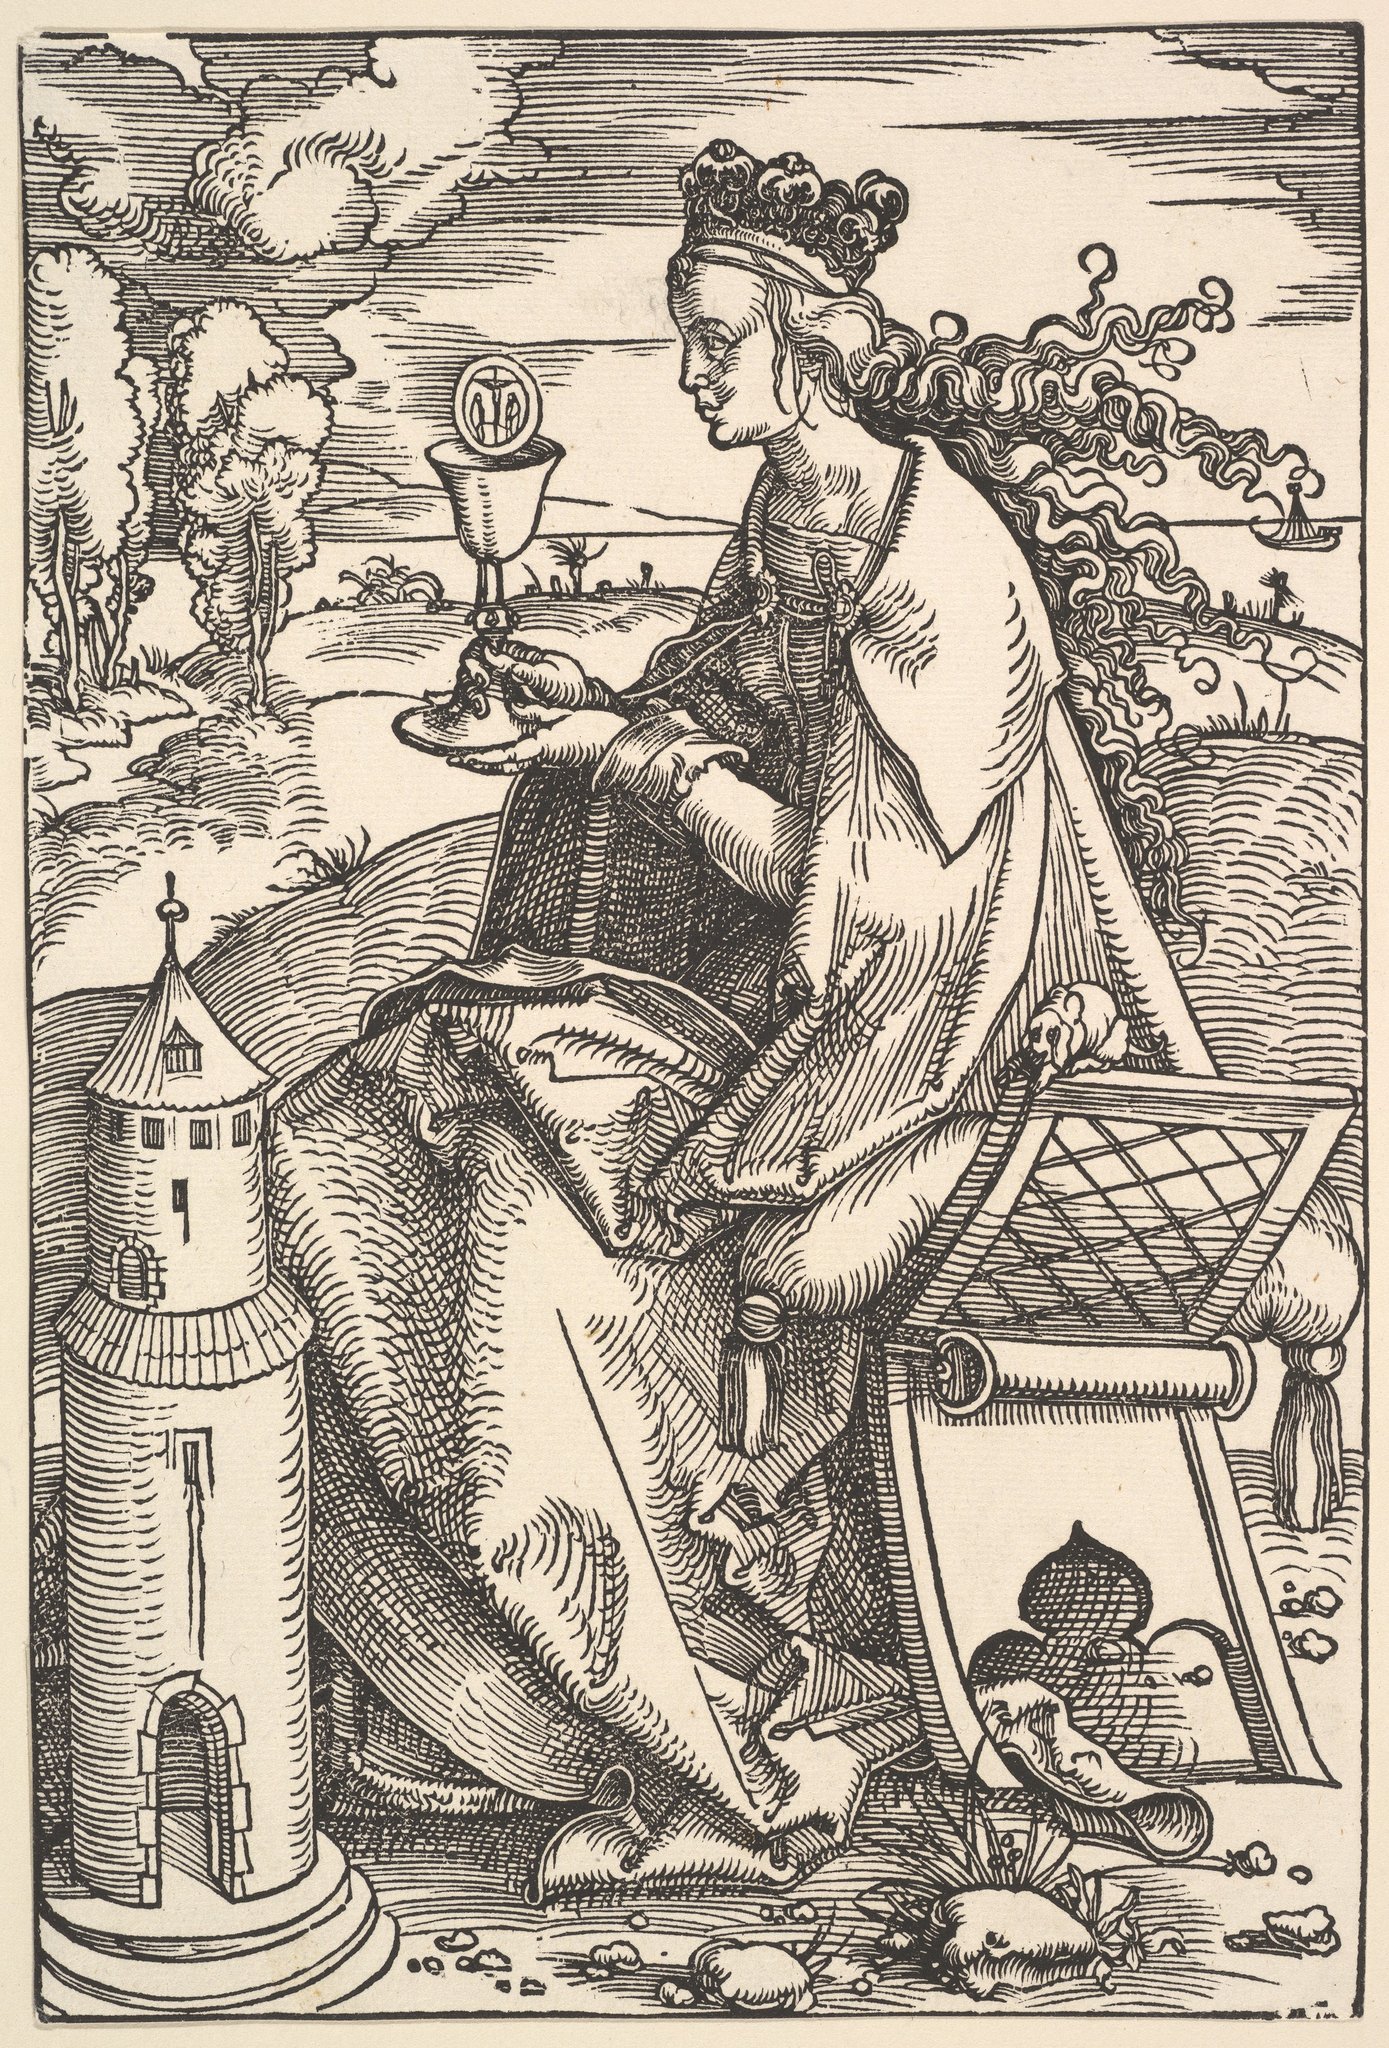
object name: print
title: St. Barbara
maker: hans baldung (called hans baldung grien)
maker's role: artist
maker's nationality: german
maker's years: 1484-1545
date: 1505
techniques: woodcut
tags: women,saints,chalices